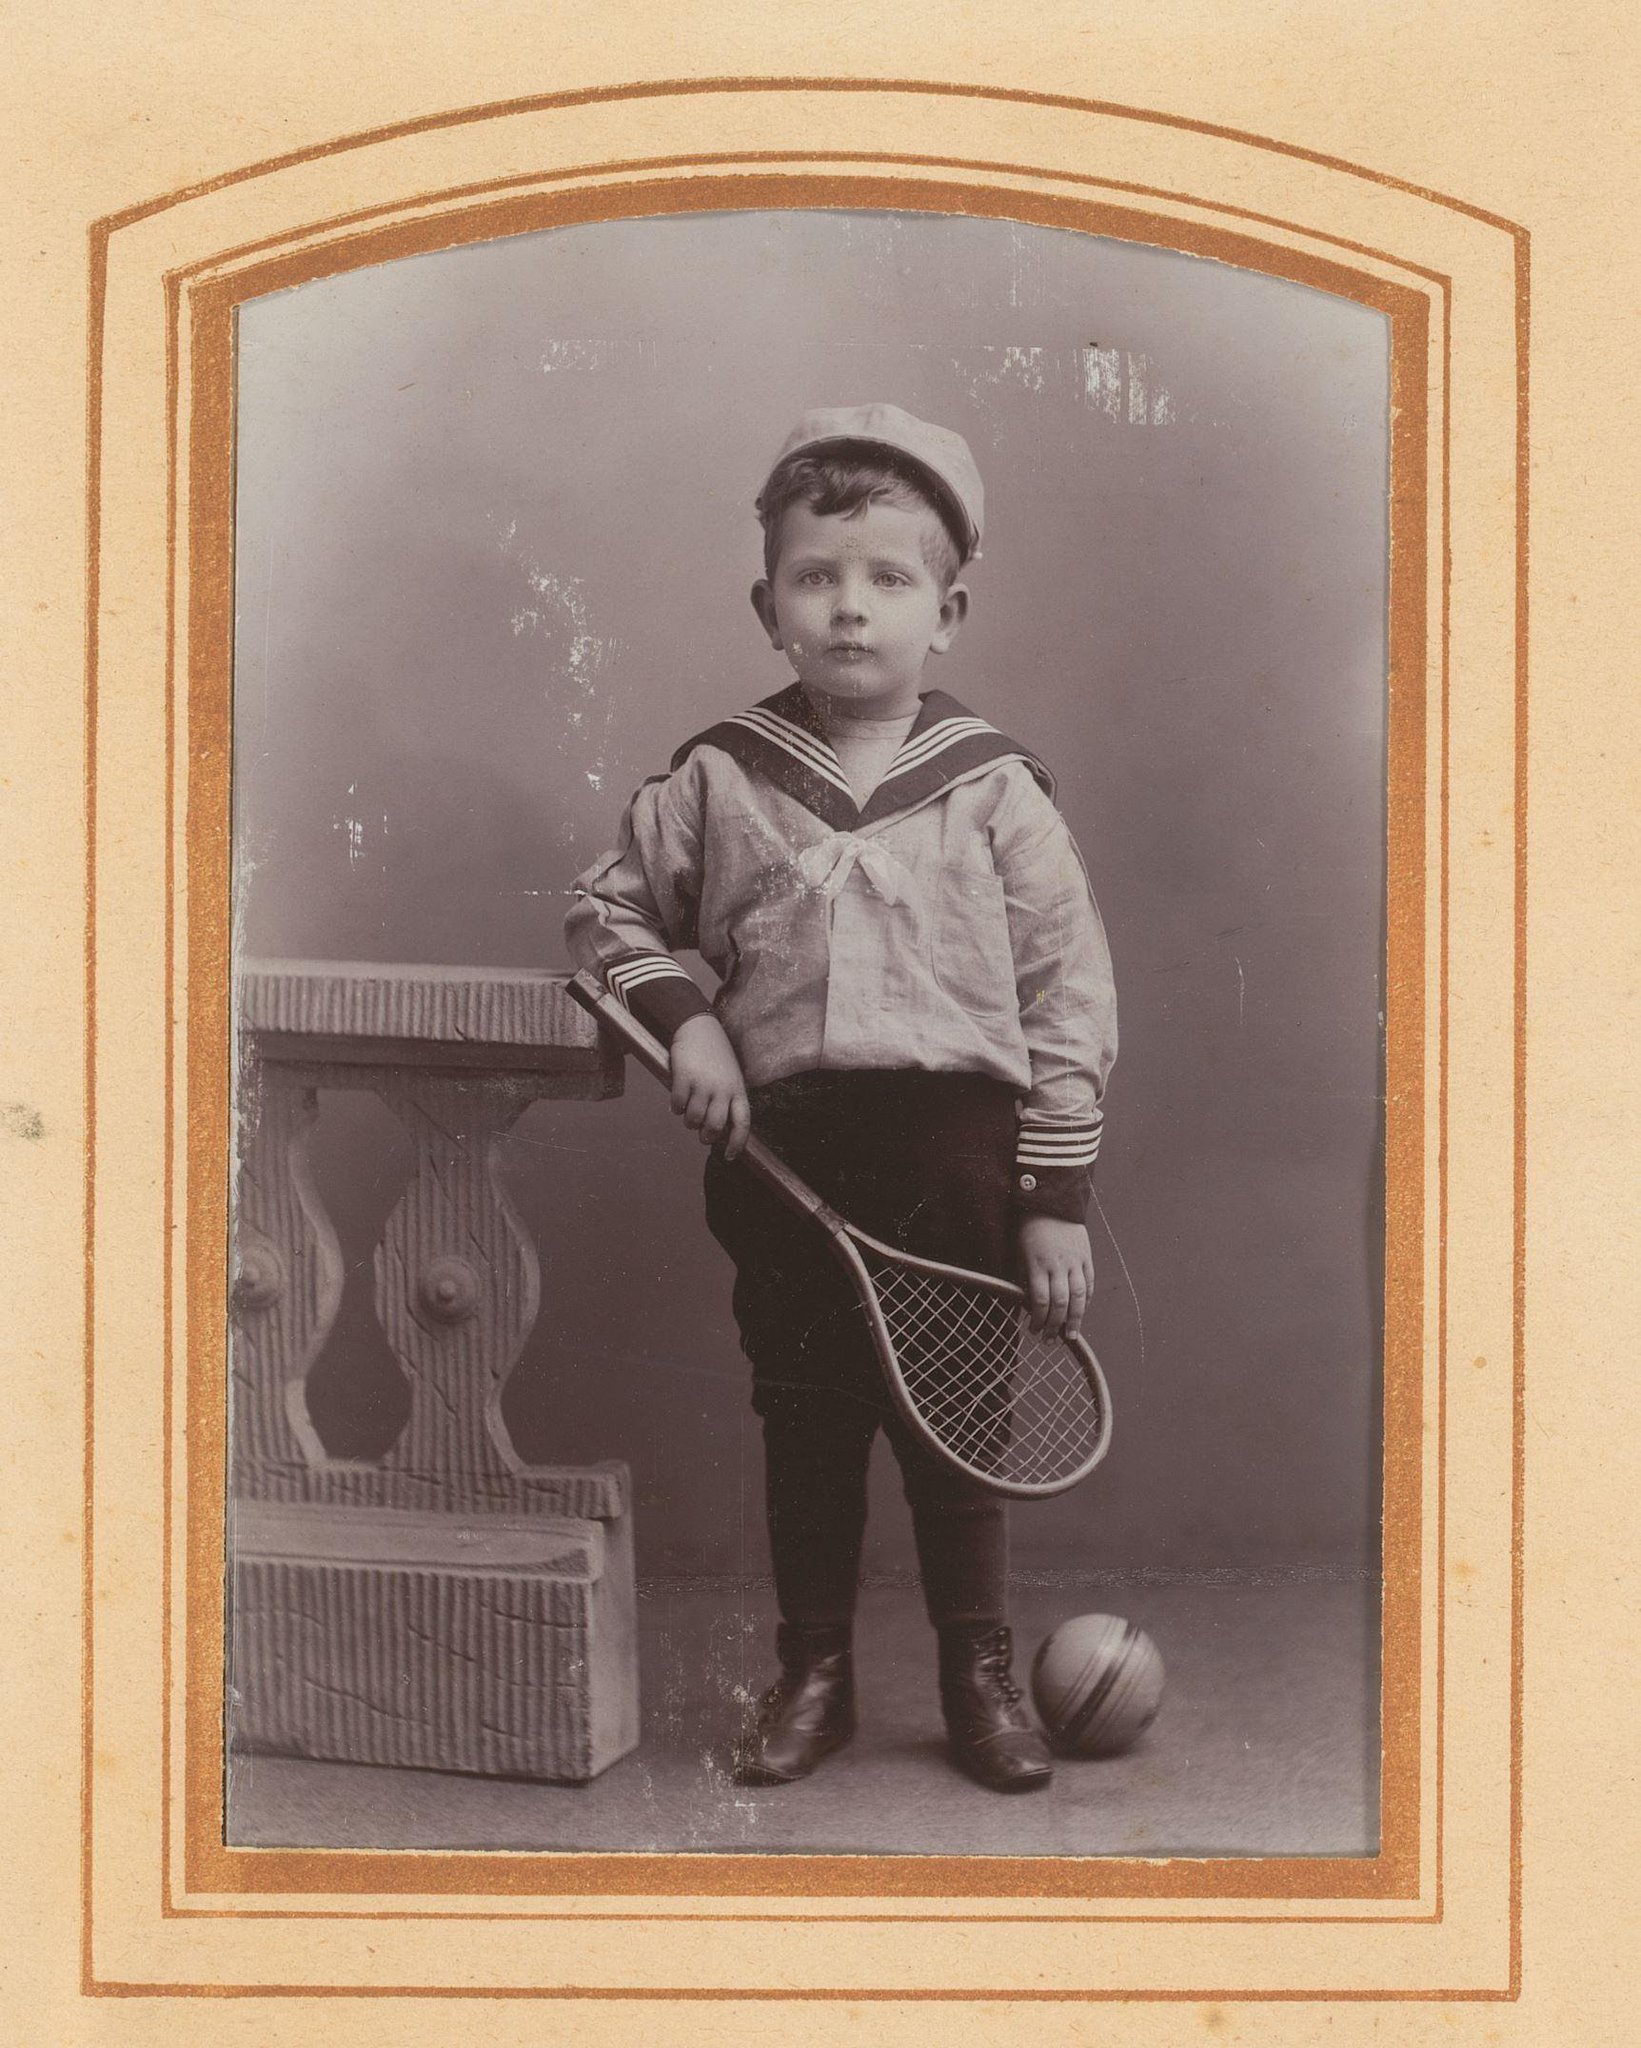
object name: cabinet photograph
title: Portret van een jongen met racket en bal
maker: jean daniel matthieu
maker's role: fotograaf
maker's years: 1865-1926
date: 1890-1926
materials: cardboard, photographic support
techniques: collodion silver print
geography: amsterdam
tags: boy (child between toddler and youth), ball games in which ball is hit with racket (or hand)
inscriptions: inscription: ‘J.D. Matthieu/ Amsterdam/ Ceintuurbaan 167’